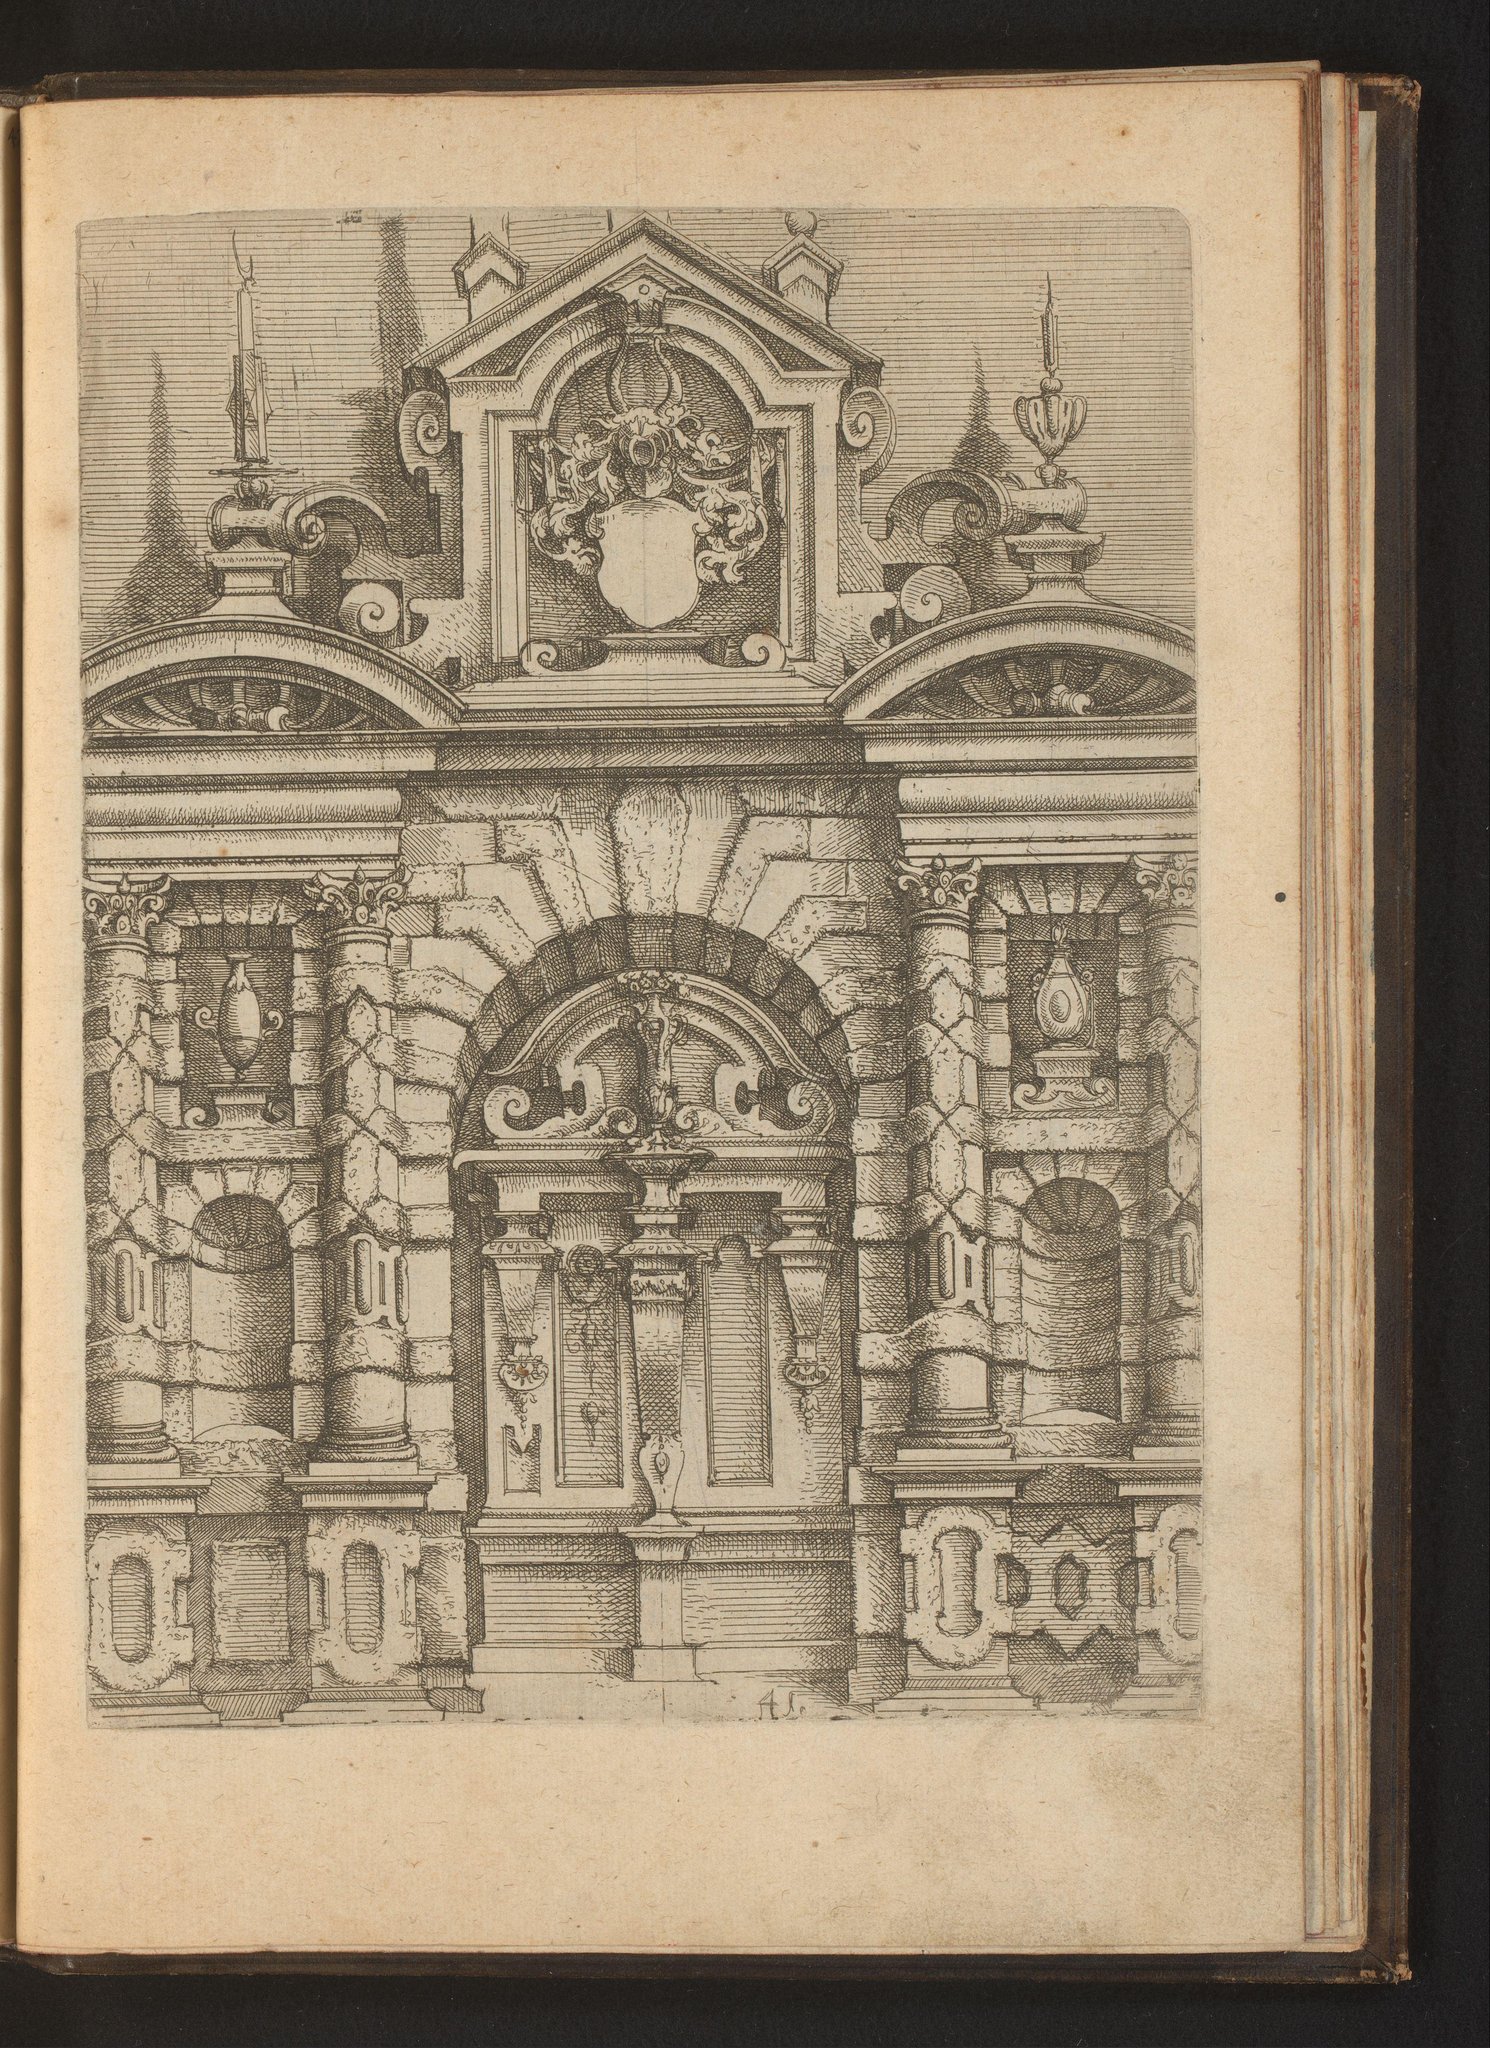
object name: ornament print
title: Architectura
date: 1593-1595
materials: paper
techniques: etching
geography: straatsburg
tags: parts of church exterior and annexes: portal, rustication ~ surface decorations (architecture), ornament derived from architectural details, corinthian order ~ architecture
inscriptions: collector's mark: Lugt 2228, collector's mark: Lugt 2760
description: Prent gebruikt in: Dietterlin, Wendel (I). Wendel Dietterlin, Architectura de Polstium seu Portalium ornatu uario Liber II. Straatsburg: Bernhard Jobin, 1594.